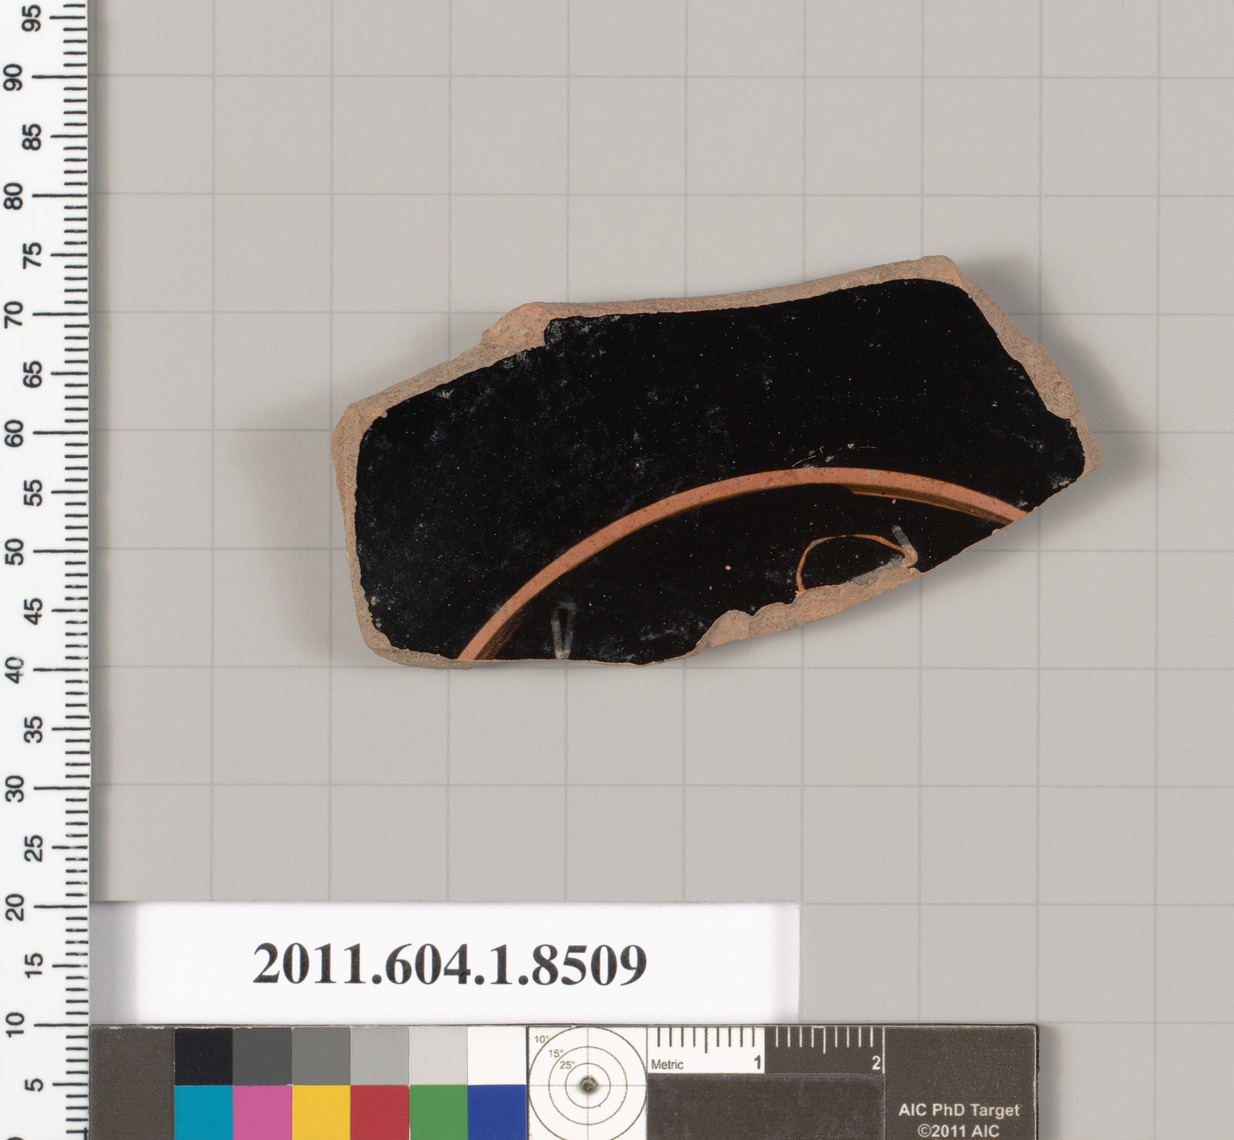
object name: kylix fragment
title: Terracotta fragment of a stemless kylix (drinking cup)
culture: greek, attic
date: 470-450 BCE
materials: terracotta